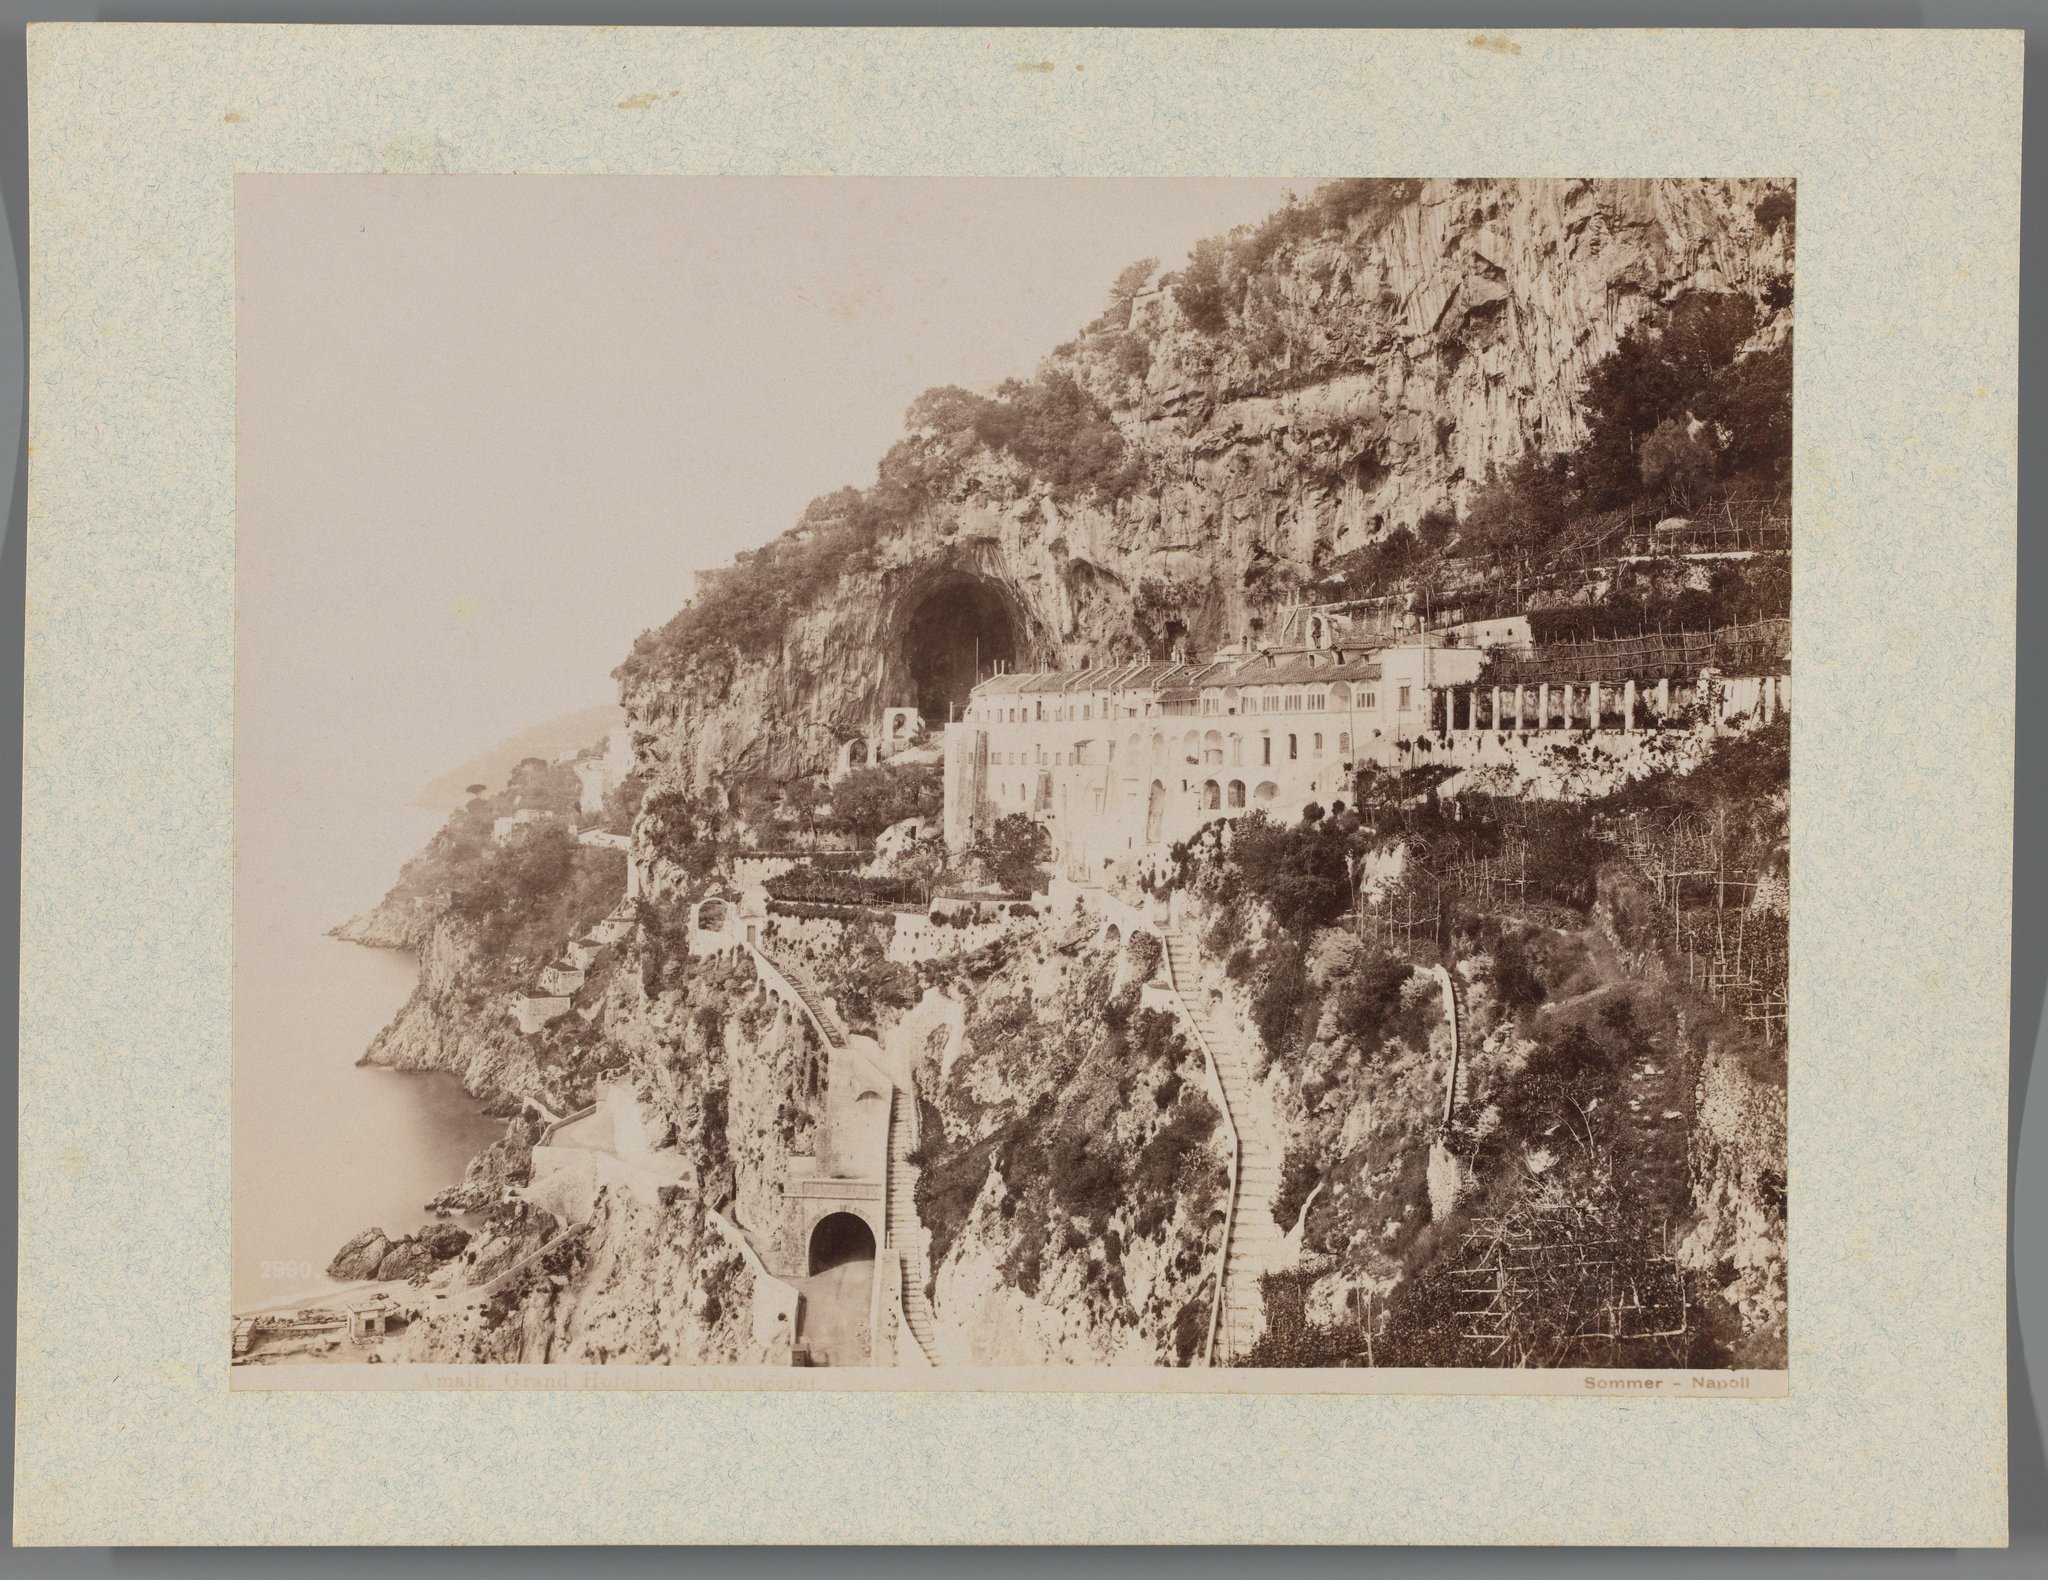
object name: photograph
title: Italië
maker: Anonymous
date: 1880-1910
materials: photographic support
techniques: albumen print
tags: italy